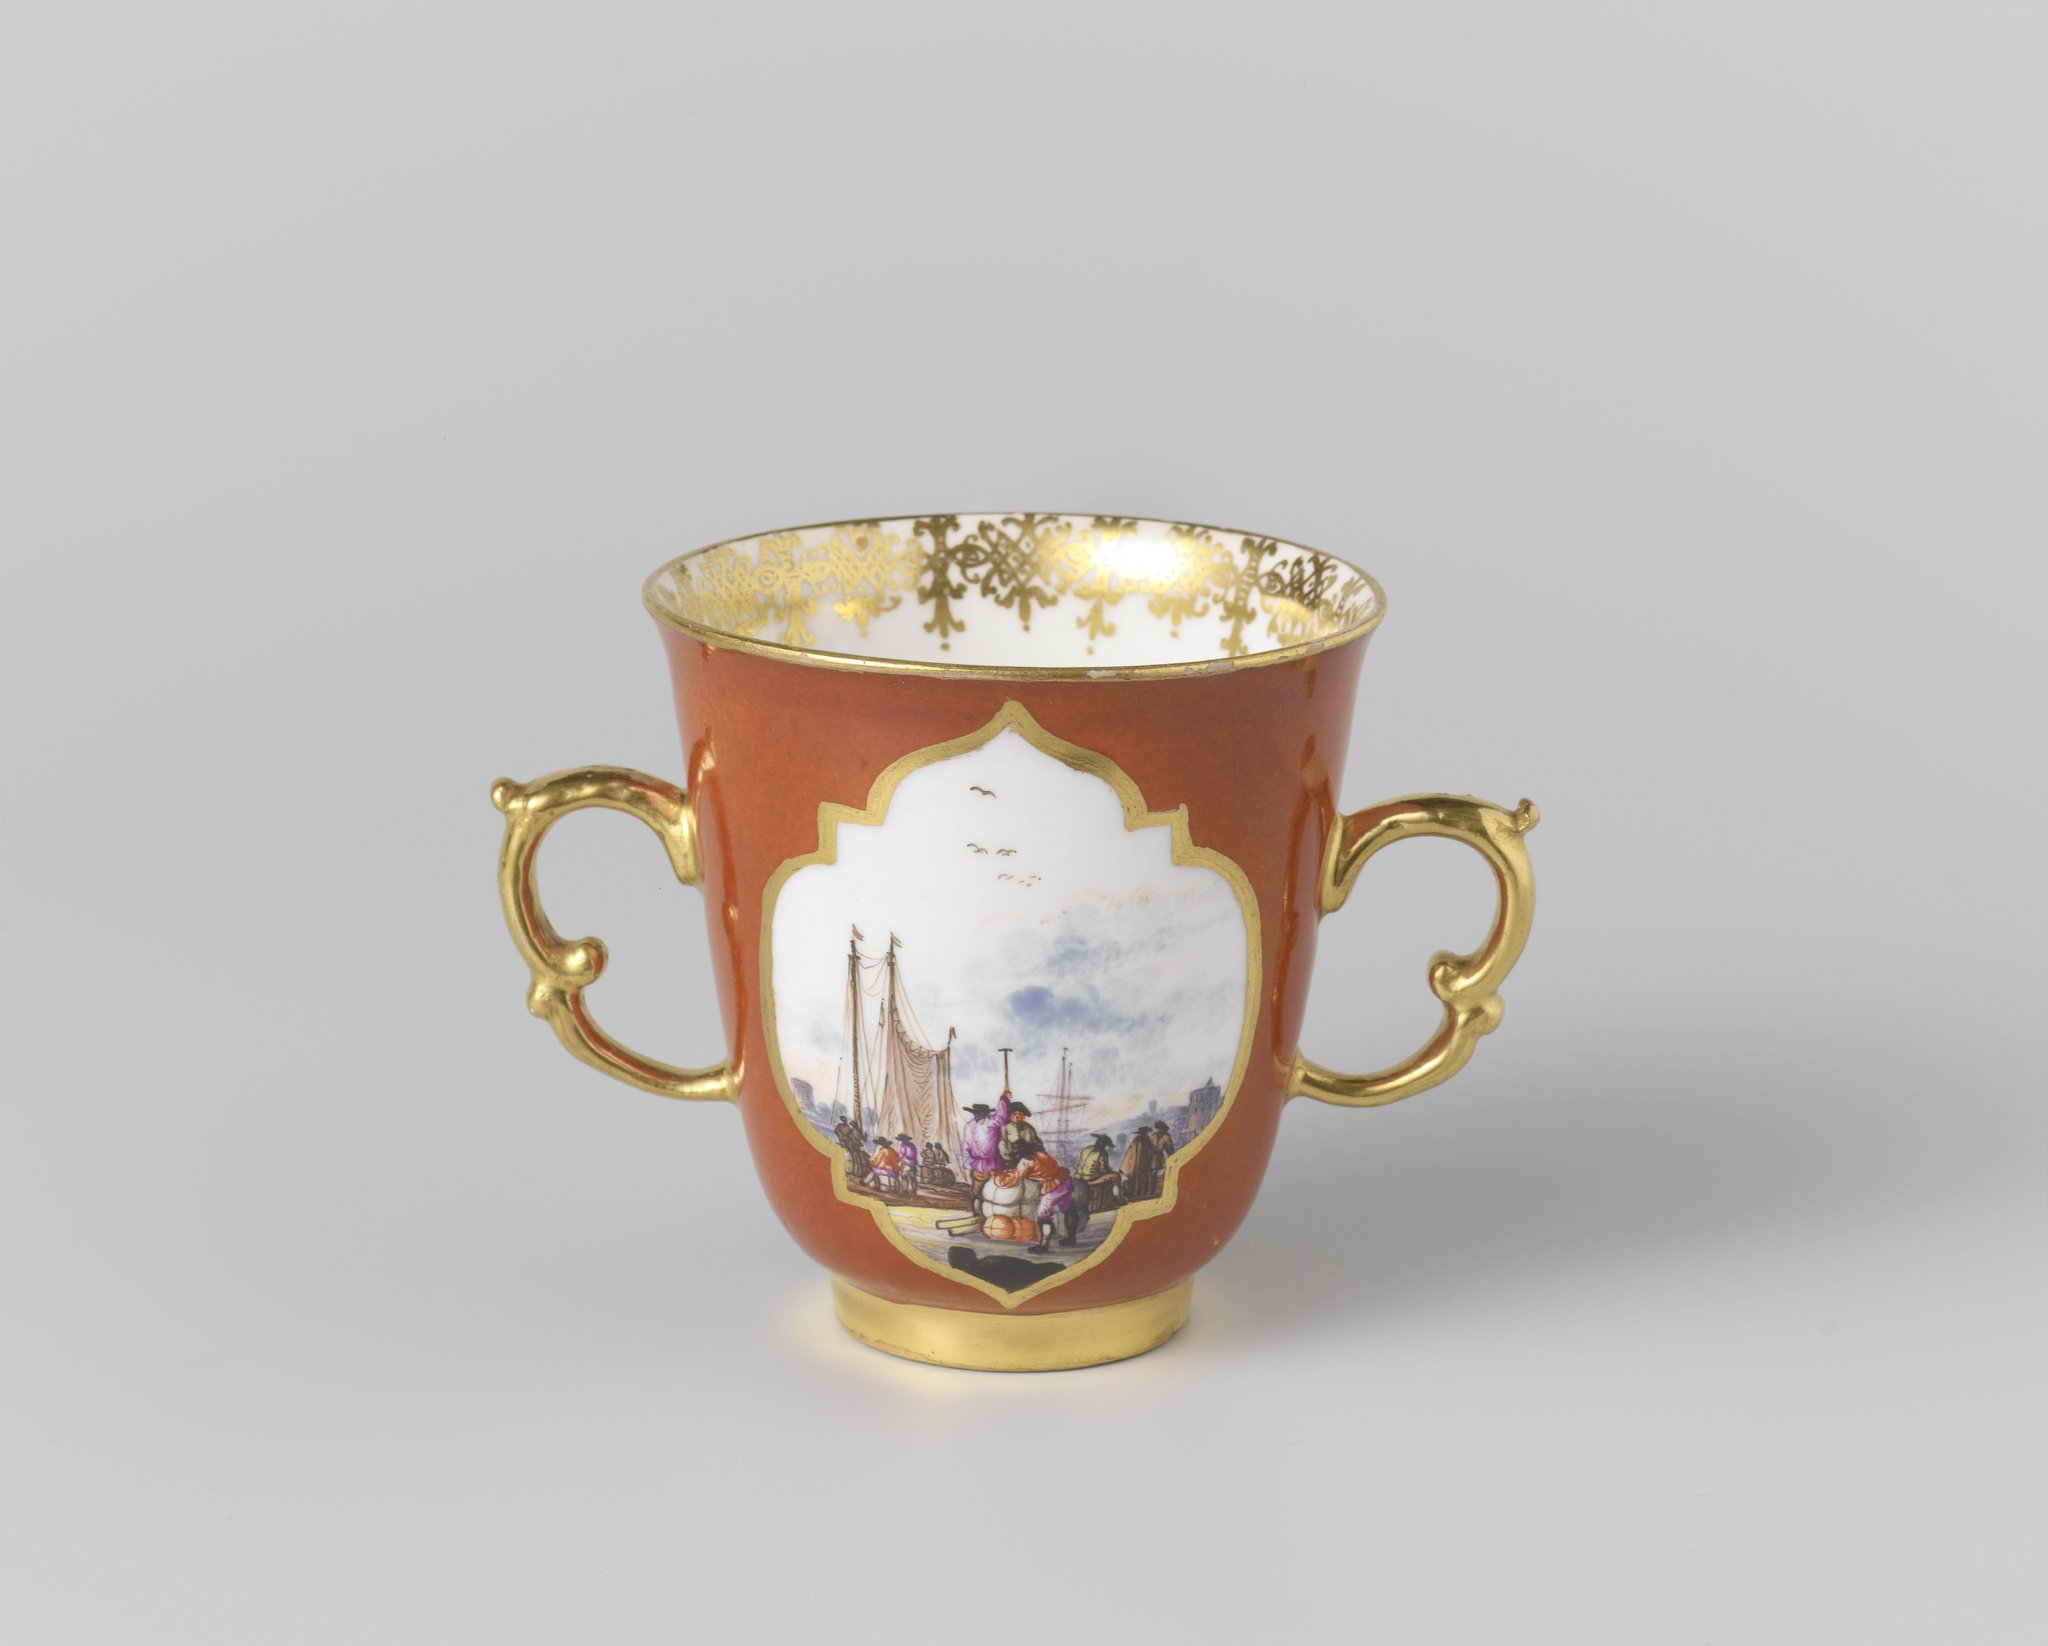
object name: chocolate cup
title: Chocoladekop, veelkleurig beschilderd met waterlandschappen in uitgespaarde vierpassen in een oranjerode fond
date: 1735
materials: porcelain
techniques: painted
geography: meissen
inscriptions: factory mark, mark: ‘27’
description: Chocoladekop van beschilderd porselein. De kop is bedekt met een oranjerode fond, waarin accoladevormige vierpassen zijn uitgespaard met (water)landschappen met europese figuren, soms bij balen en schepen. De kop is gemerkt en hoort bij een thee- en chocolaeservies (BK-17402-A t/m BK-17402-X).